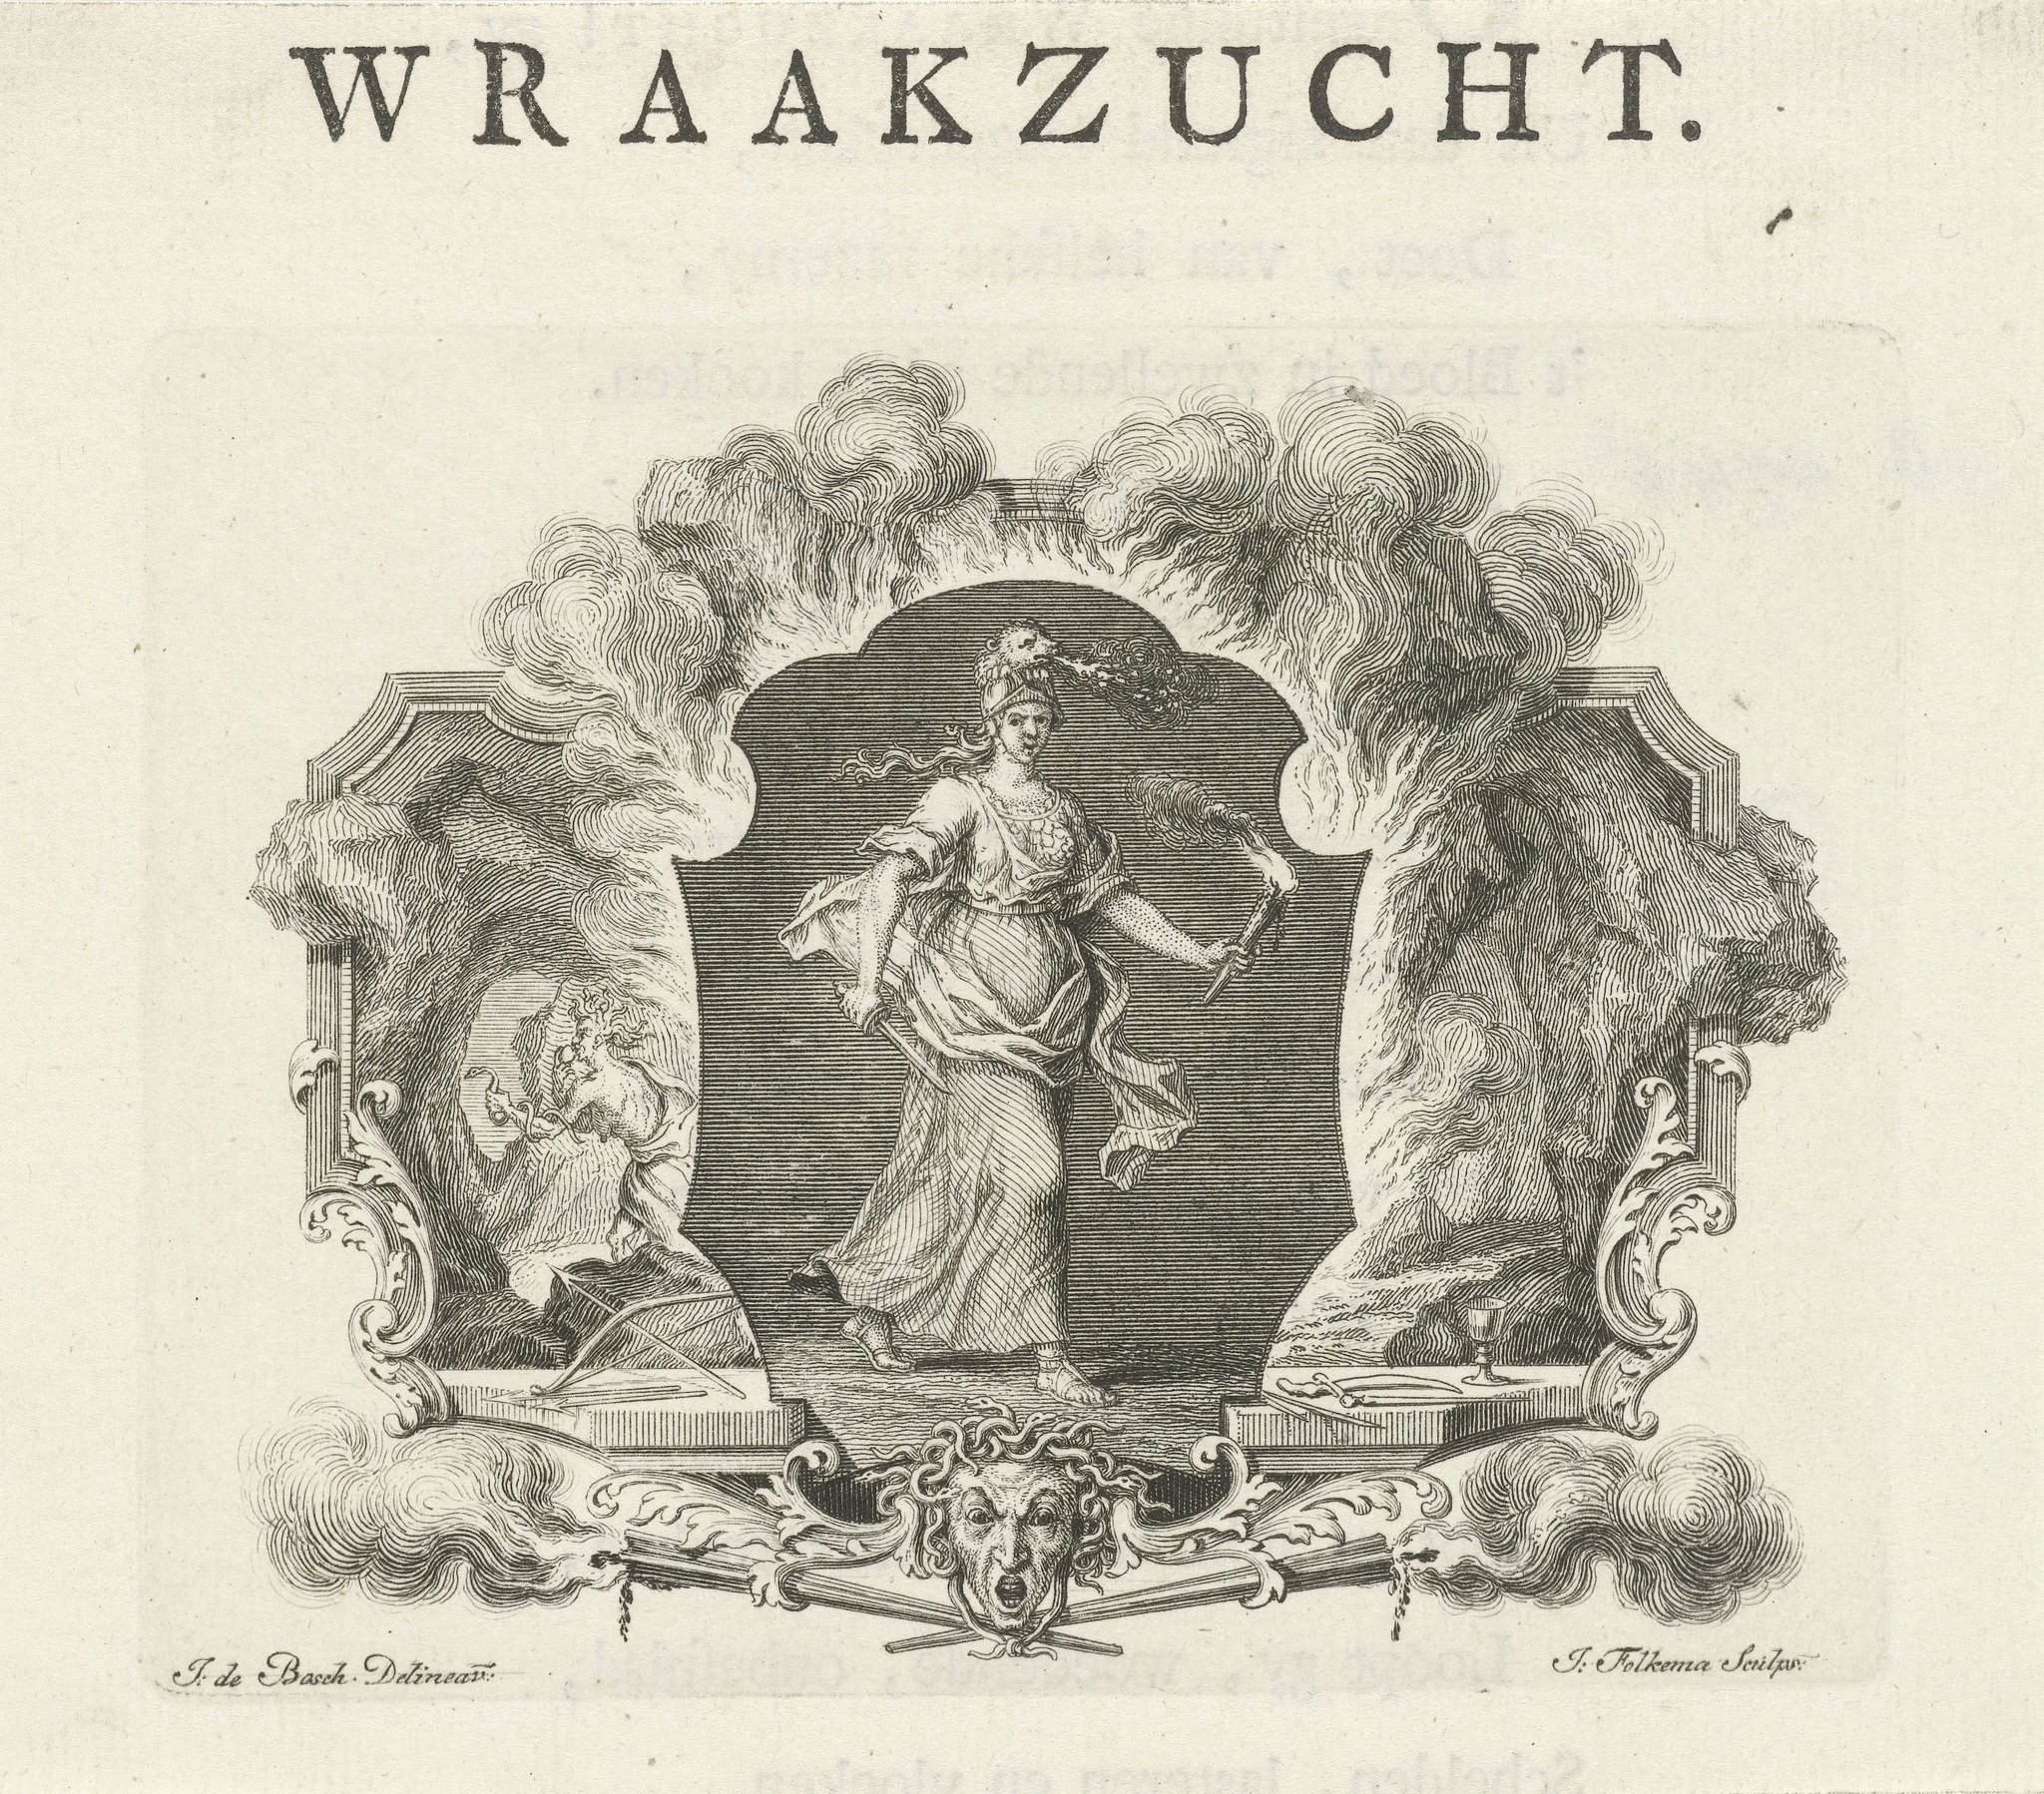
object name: print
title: Deugden en ondeugden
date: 1723-1767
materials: paper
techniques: etching, letterpress printing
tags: indignation; 'sdegno' (ripa)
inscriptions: collector's mark: Lugt 2228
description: Vignet met de beeltenis van de gepersonifieerde Wraakzucht, geplaatst in een sierlijke lijst dat gedeeltelijk in rook is gehuld. Onderin de omlijsting staan een duivelse kop met slangenharen en twee gekruiste brandende toortsen afgebeeld. De Wraakzucht houdt een dolk en een brandende toorts in haar handen, haar hoofd is getooid met een helm waarop een kop van een vuurspuwende beer is geplaatst. De prent maakt deel uit van een reeks boekillustraties over deugden en ondeugden.